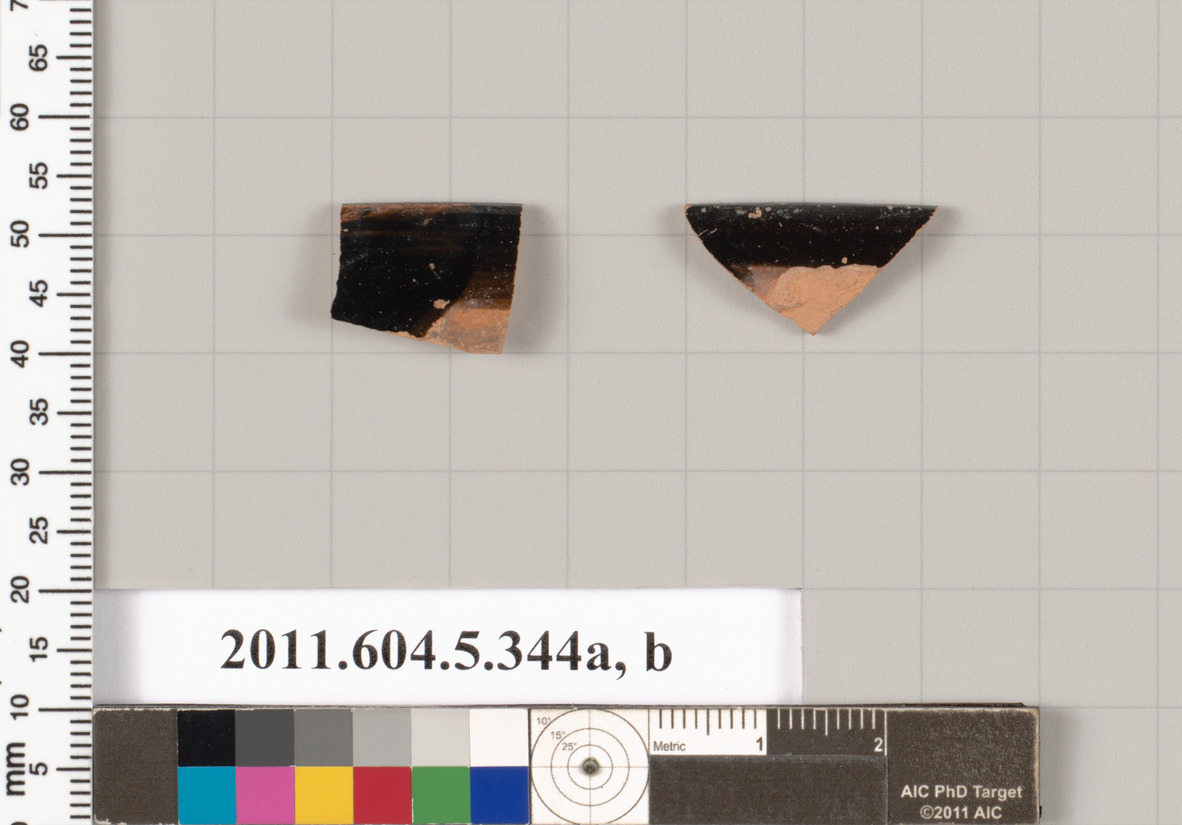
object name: kylix fragment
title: Terracotta rim fragments of kylikes (drinking cups)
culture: greek, attic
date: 600-401 BCE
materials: terracotta